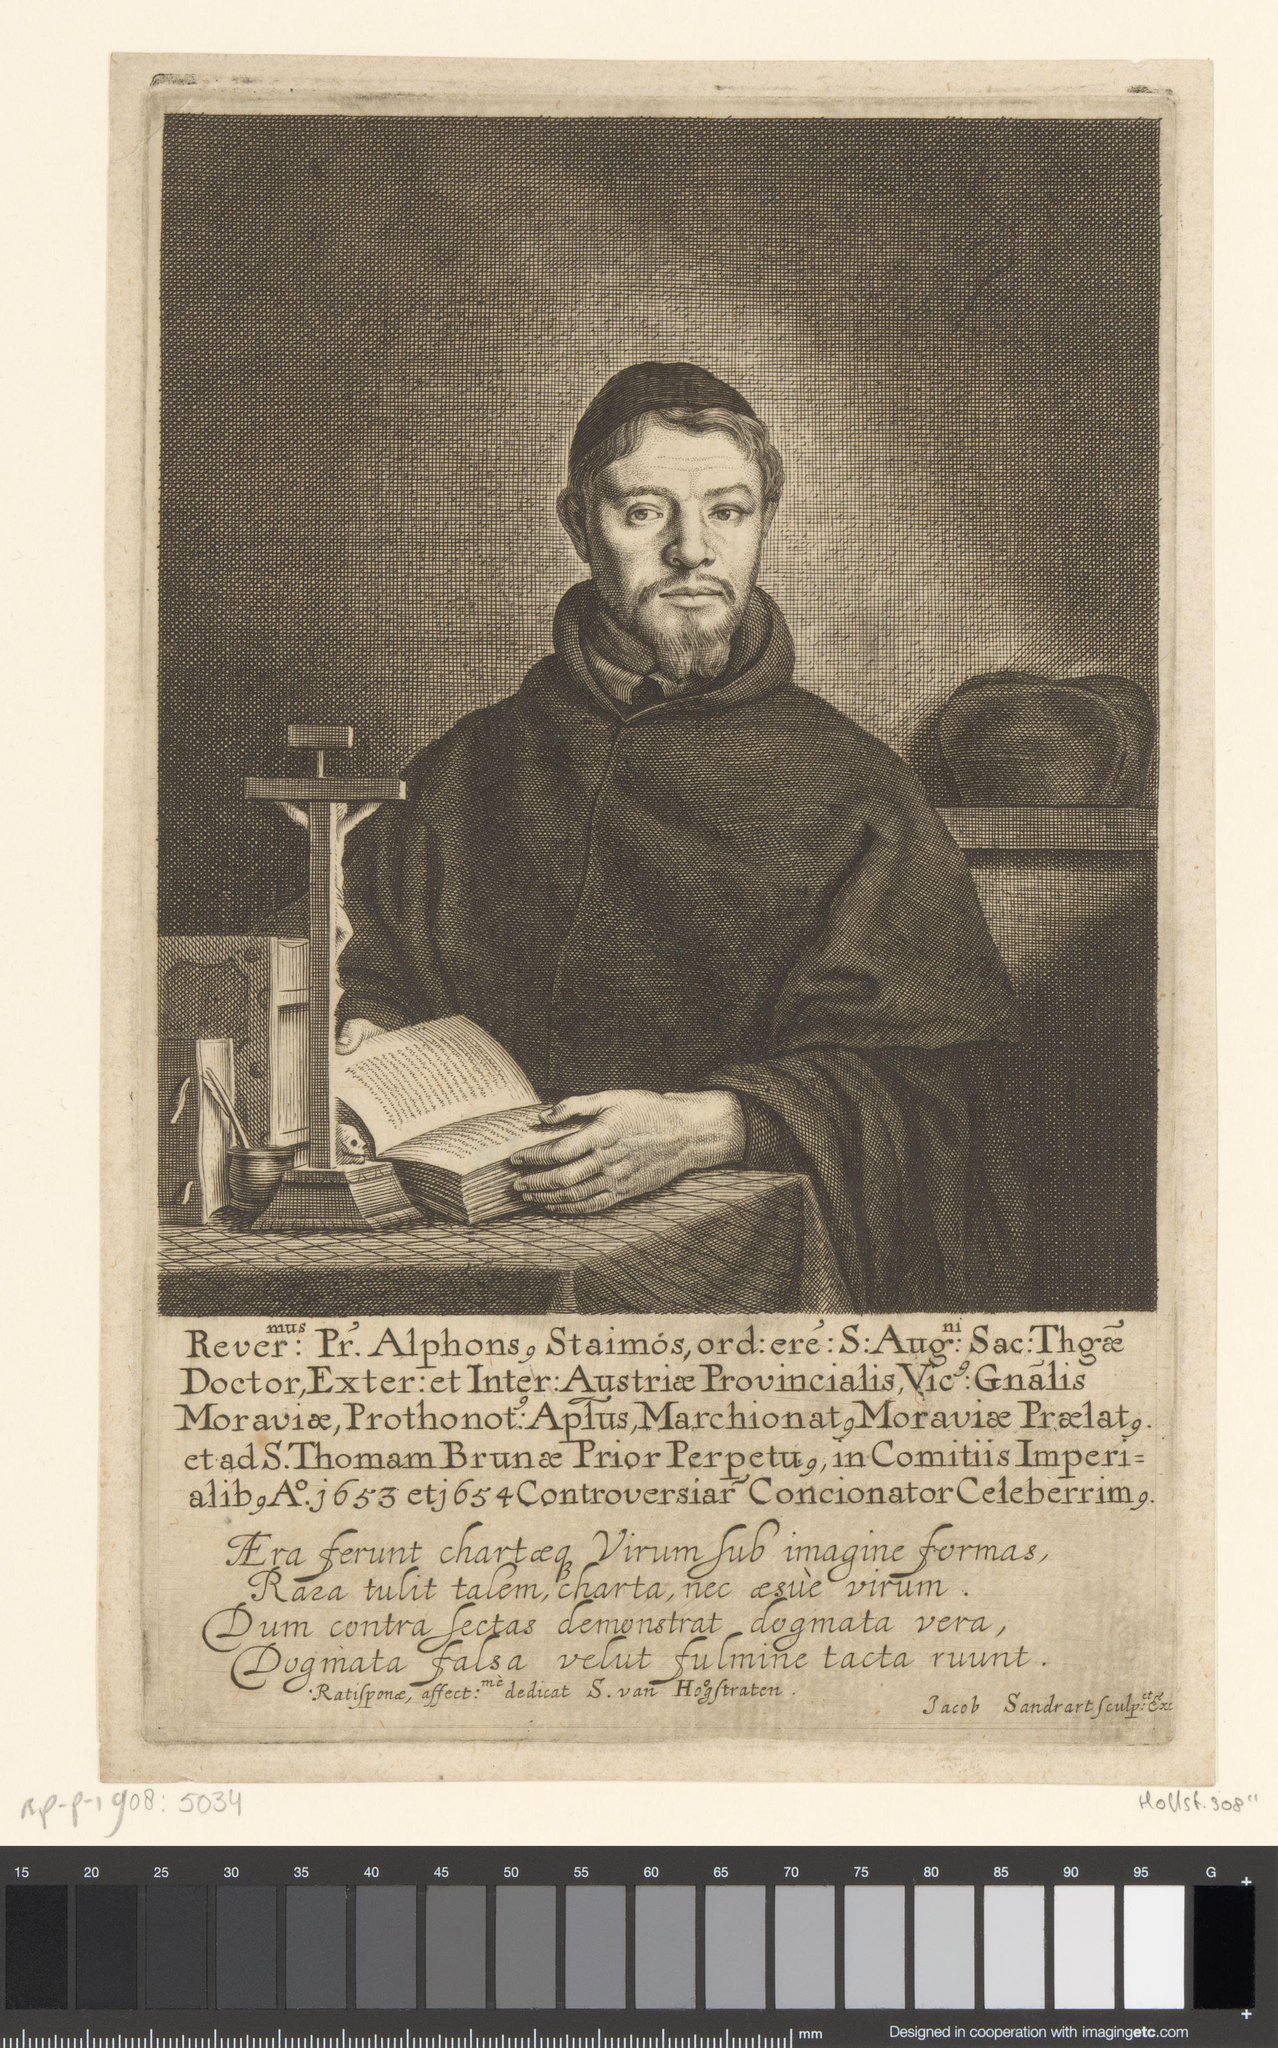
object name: print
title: Portret van Alphons Steinmoos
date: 1654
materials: paper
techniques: engraving, intaglio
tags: theologian, historical persons, book, crucifix ~ personal devotion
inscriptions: collector's mark: Lugt 2228